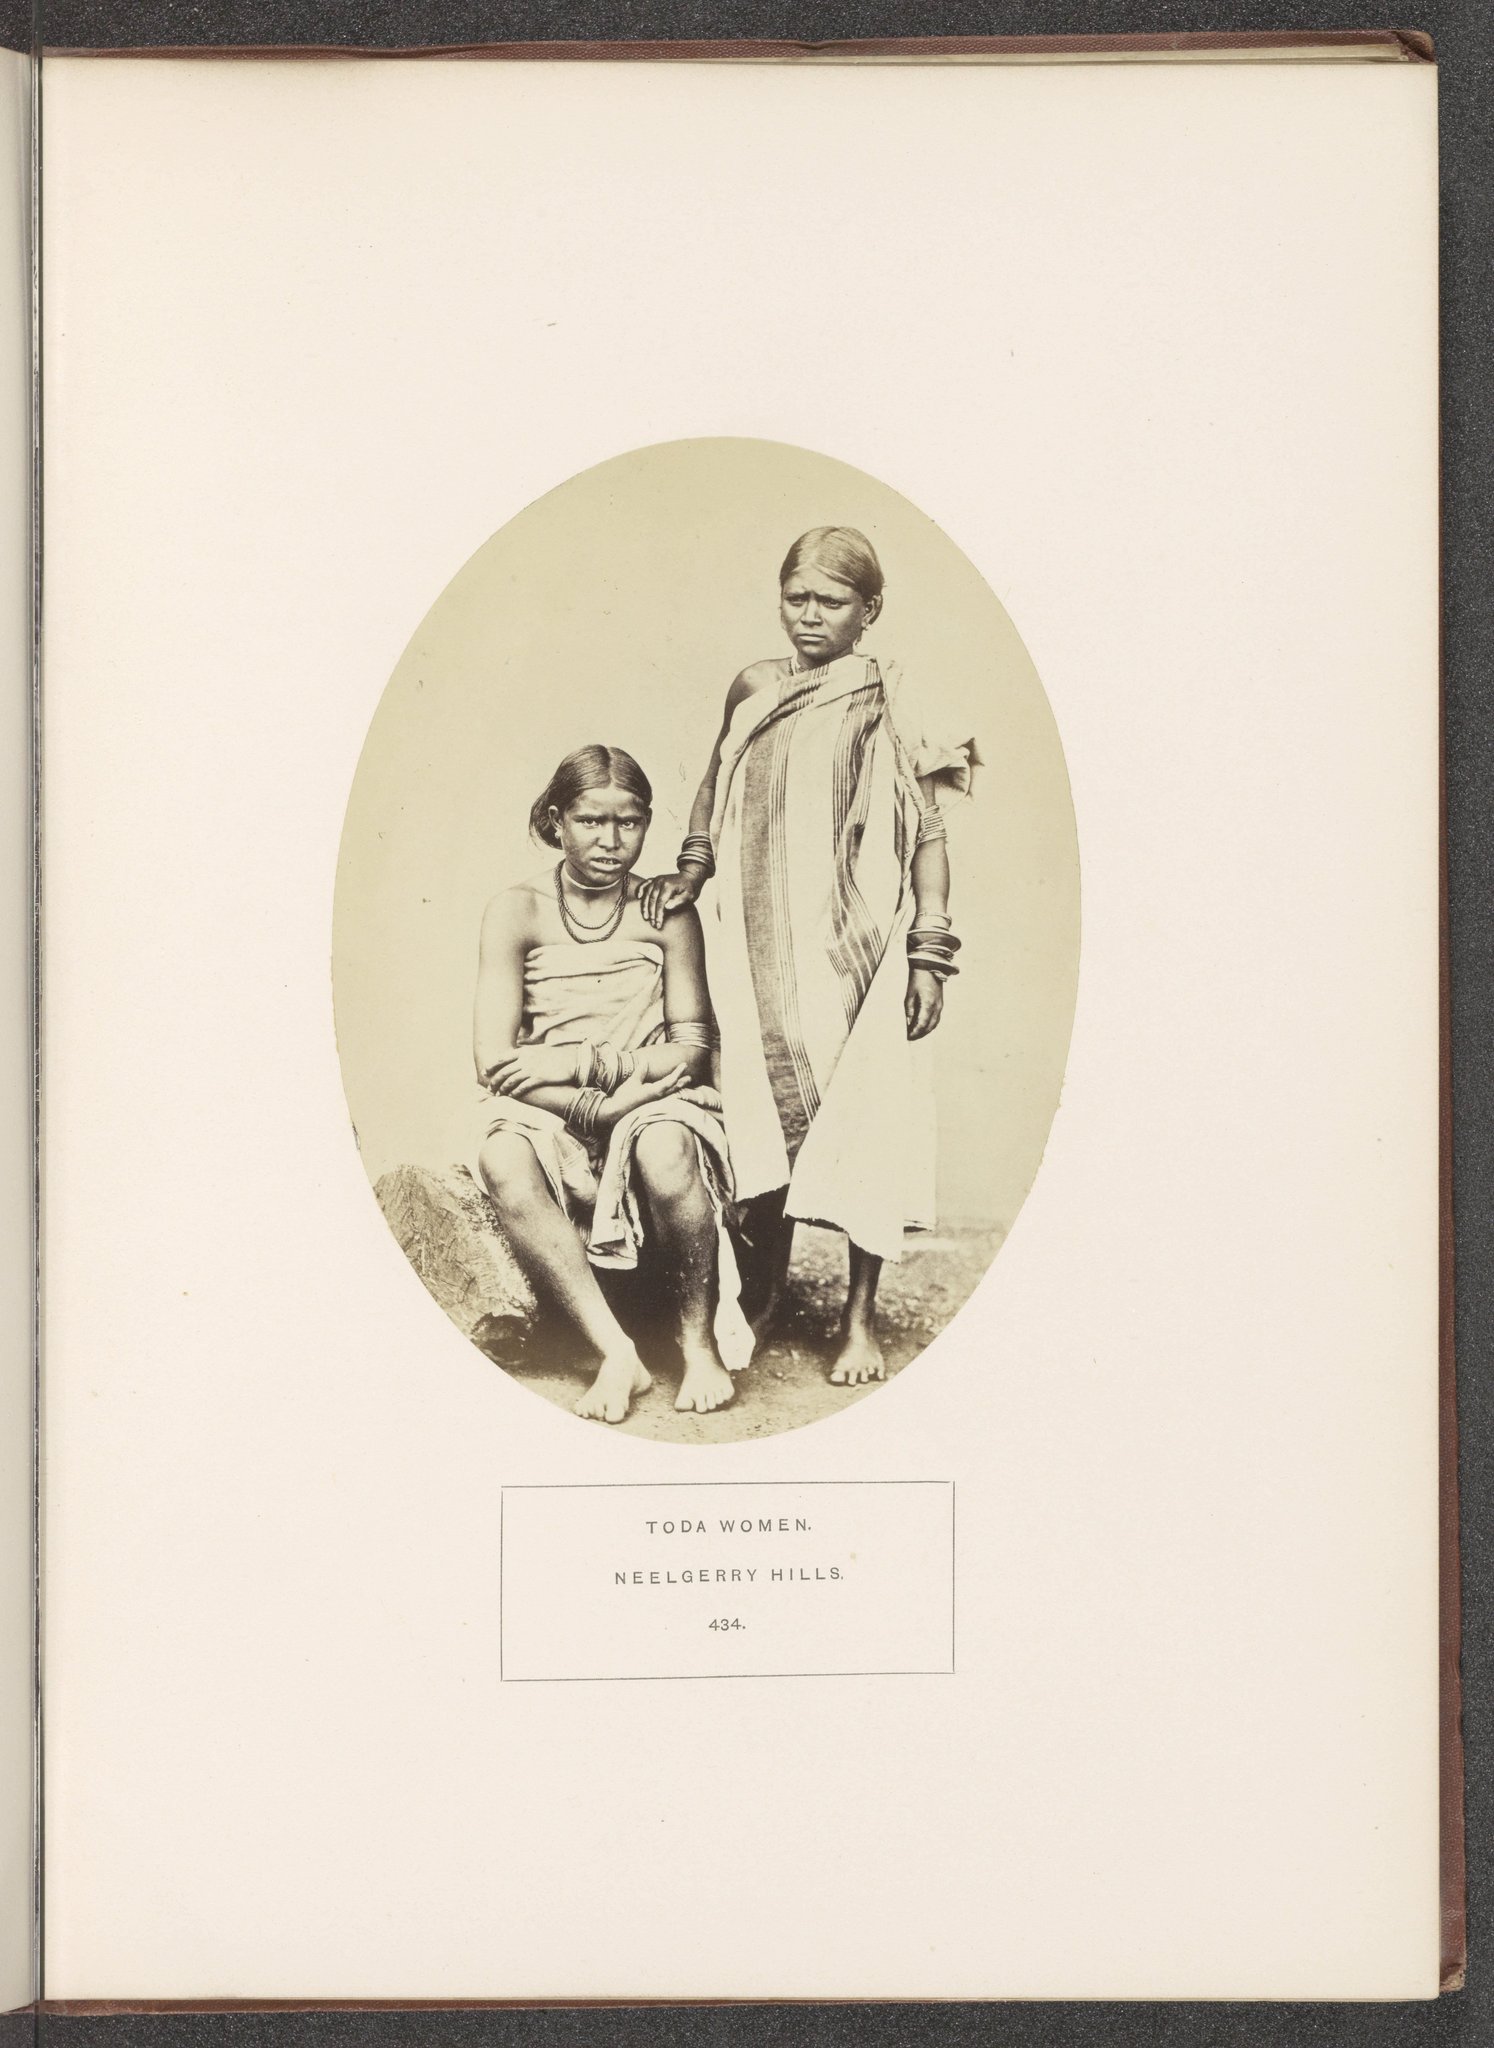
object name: page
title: Portrait of two Toda women from the Toda tribe of the Nilgiri mountains in Tamil Nadu, India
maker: Anonymous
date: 1865-1875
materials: photographic support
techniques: albumen print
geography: nilgiris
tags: human races; peoples; nationalities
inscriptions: inscription: ‘TODA WOMEN./ NEELGERRY HILLS.’, number: ‘434.’